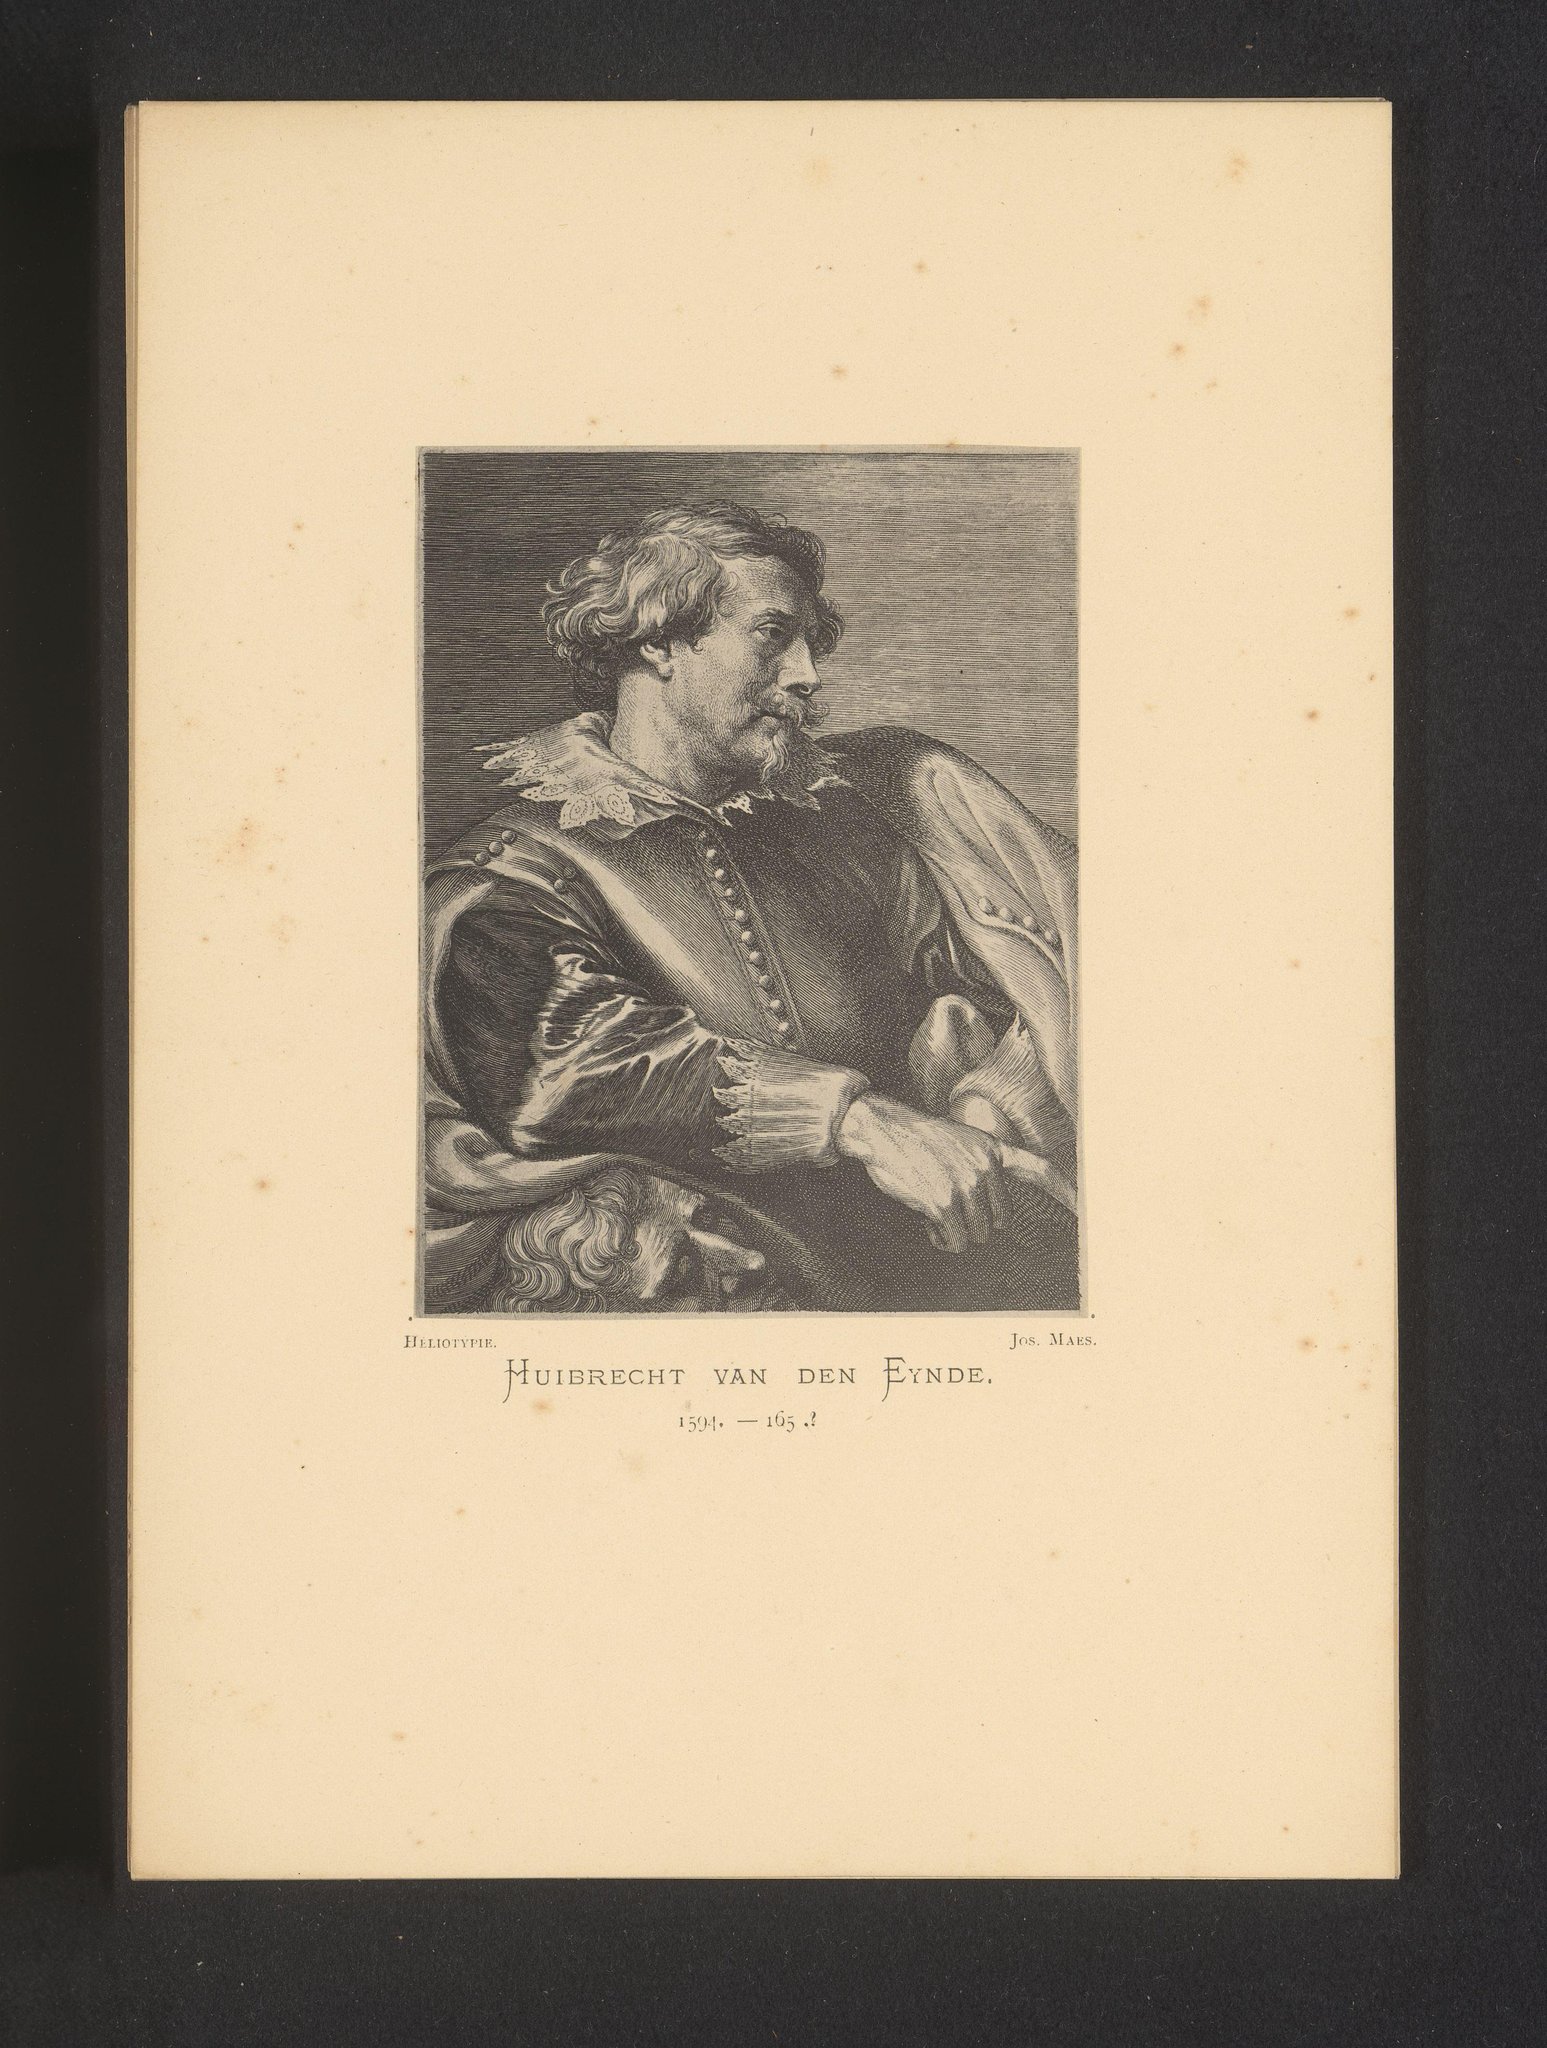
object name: reproduction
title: Reproductie van een gravure van een portret van Hubrecht van den Eynde door Lucas Vorsterman (I)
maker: joseph maes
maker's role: fotograaf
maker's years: 1838-1908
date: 1872-1877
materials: cardboard, paper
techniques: photograph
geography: antwerp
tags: sculptor, historical persons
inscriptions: inscription: ‘1594. - 165.?’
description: Deze prent maakt deel uit van een omslag met 150 prenten en een katern met een lijst van afbeeldingen.